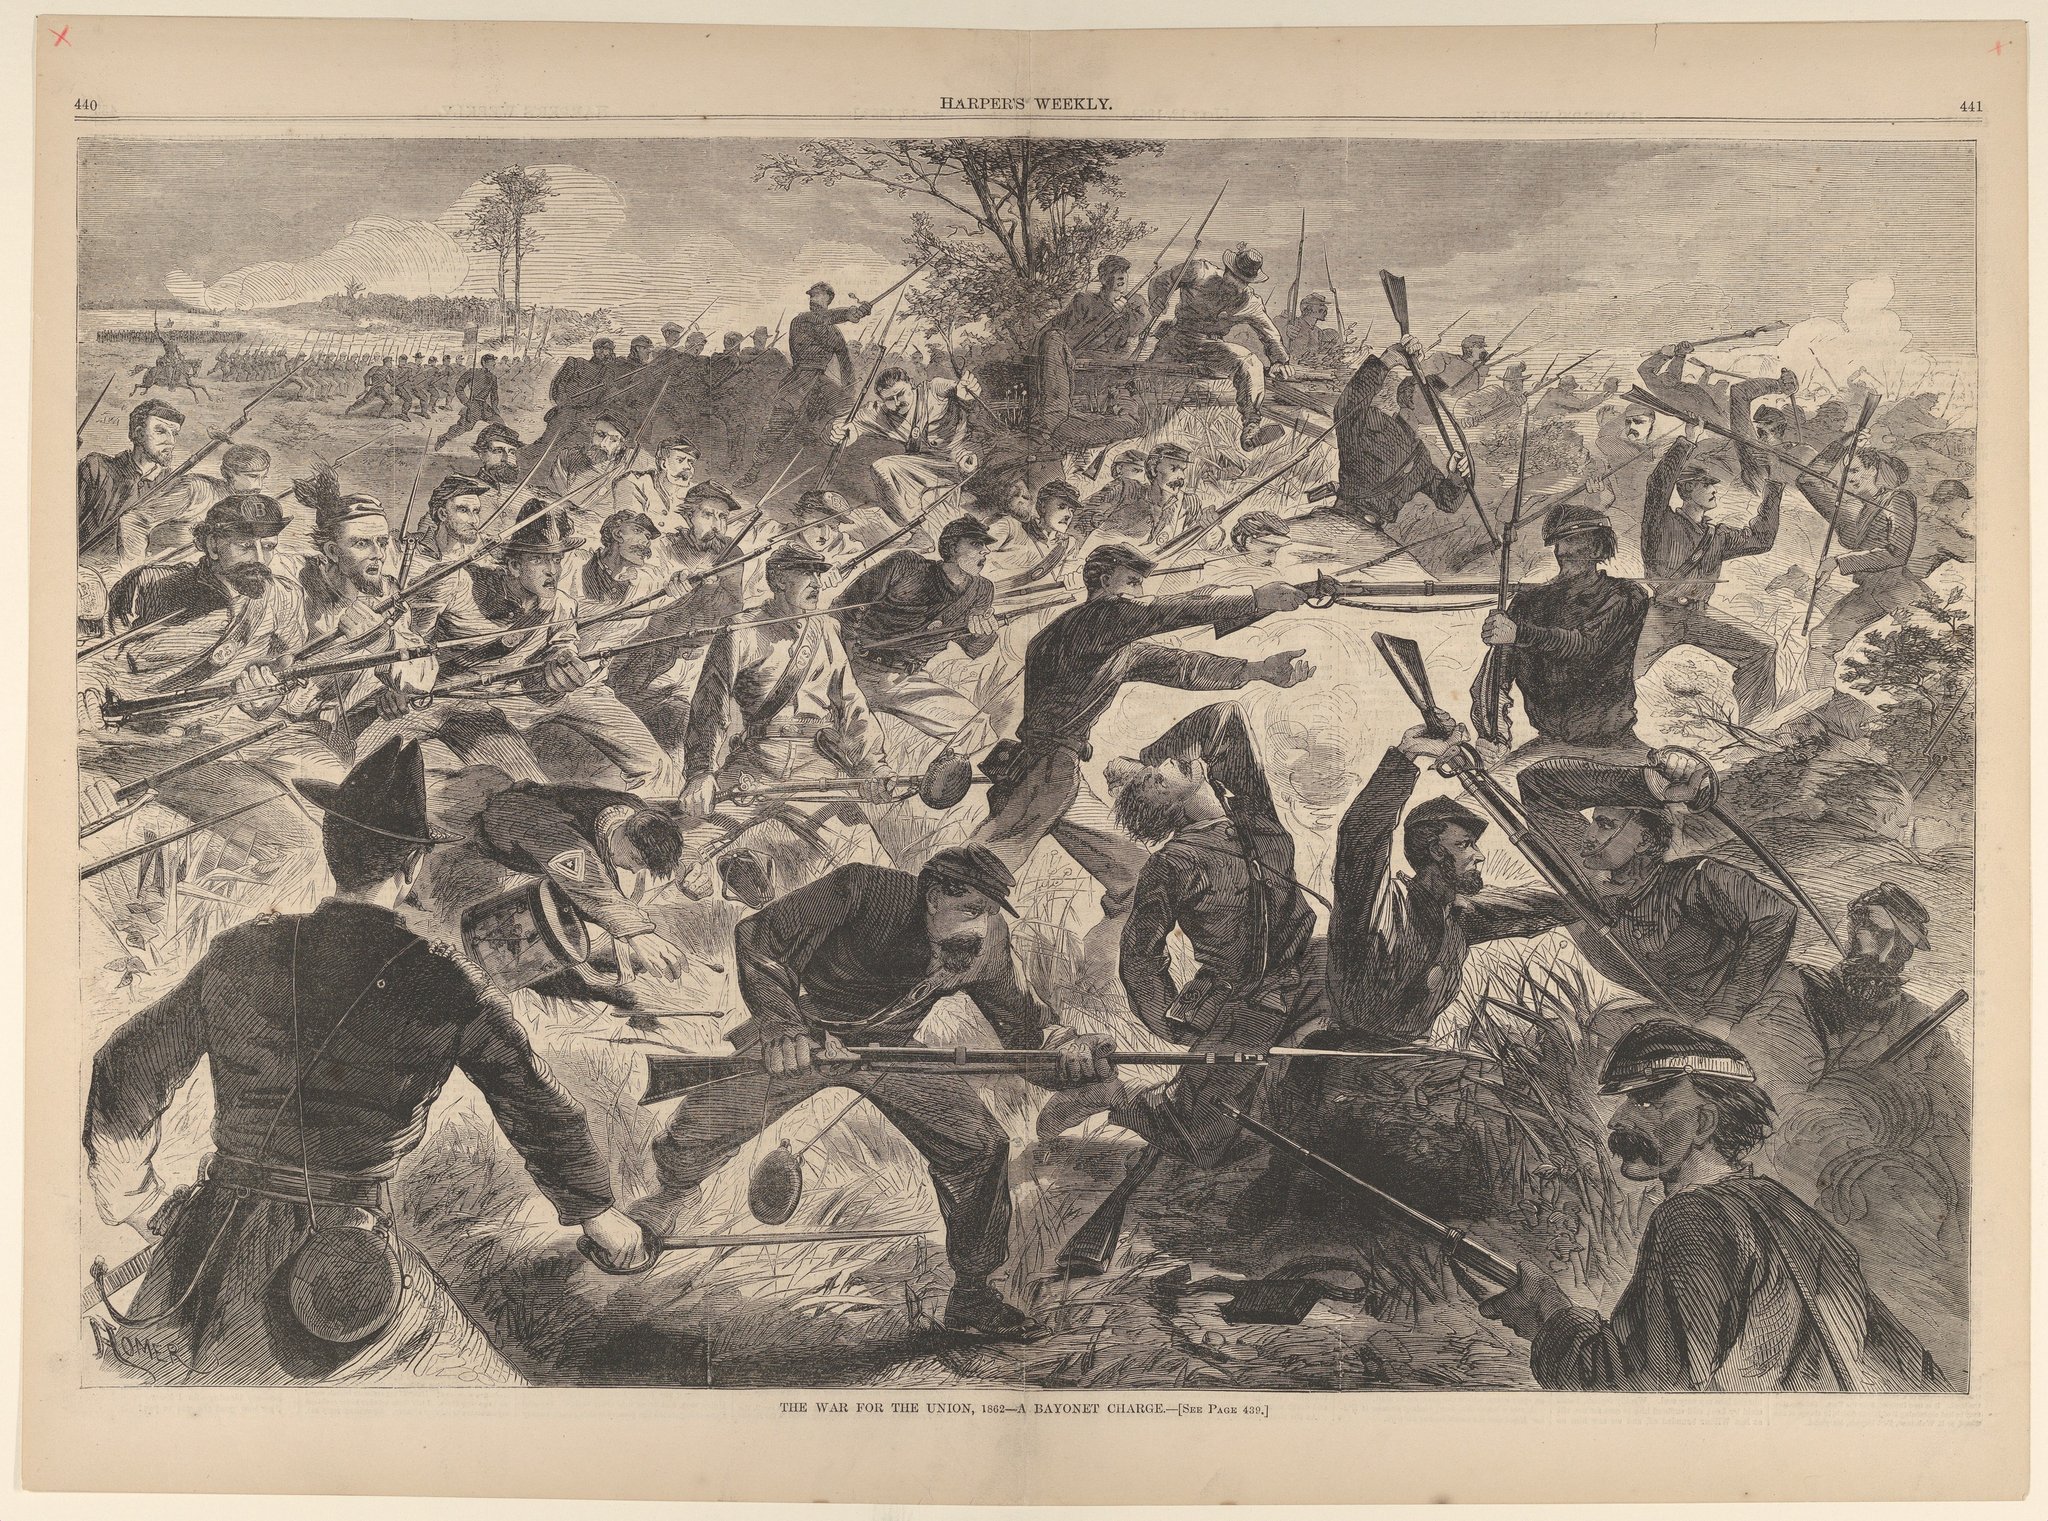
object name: print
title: The War for the Union, 1862 – A Bayonet Charge (from "Harper's Weekly," Vol. VII)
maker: winslow homer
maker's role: artist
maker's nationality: american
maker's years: 1836-1910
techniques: engraving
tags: battles,soldiers,american civil war,men